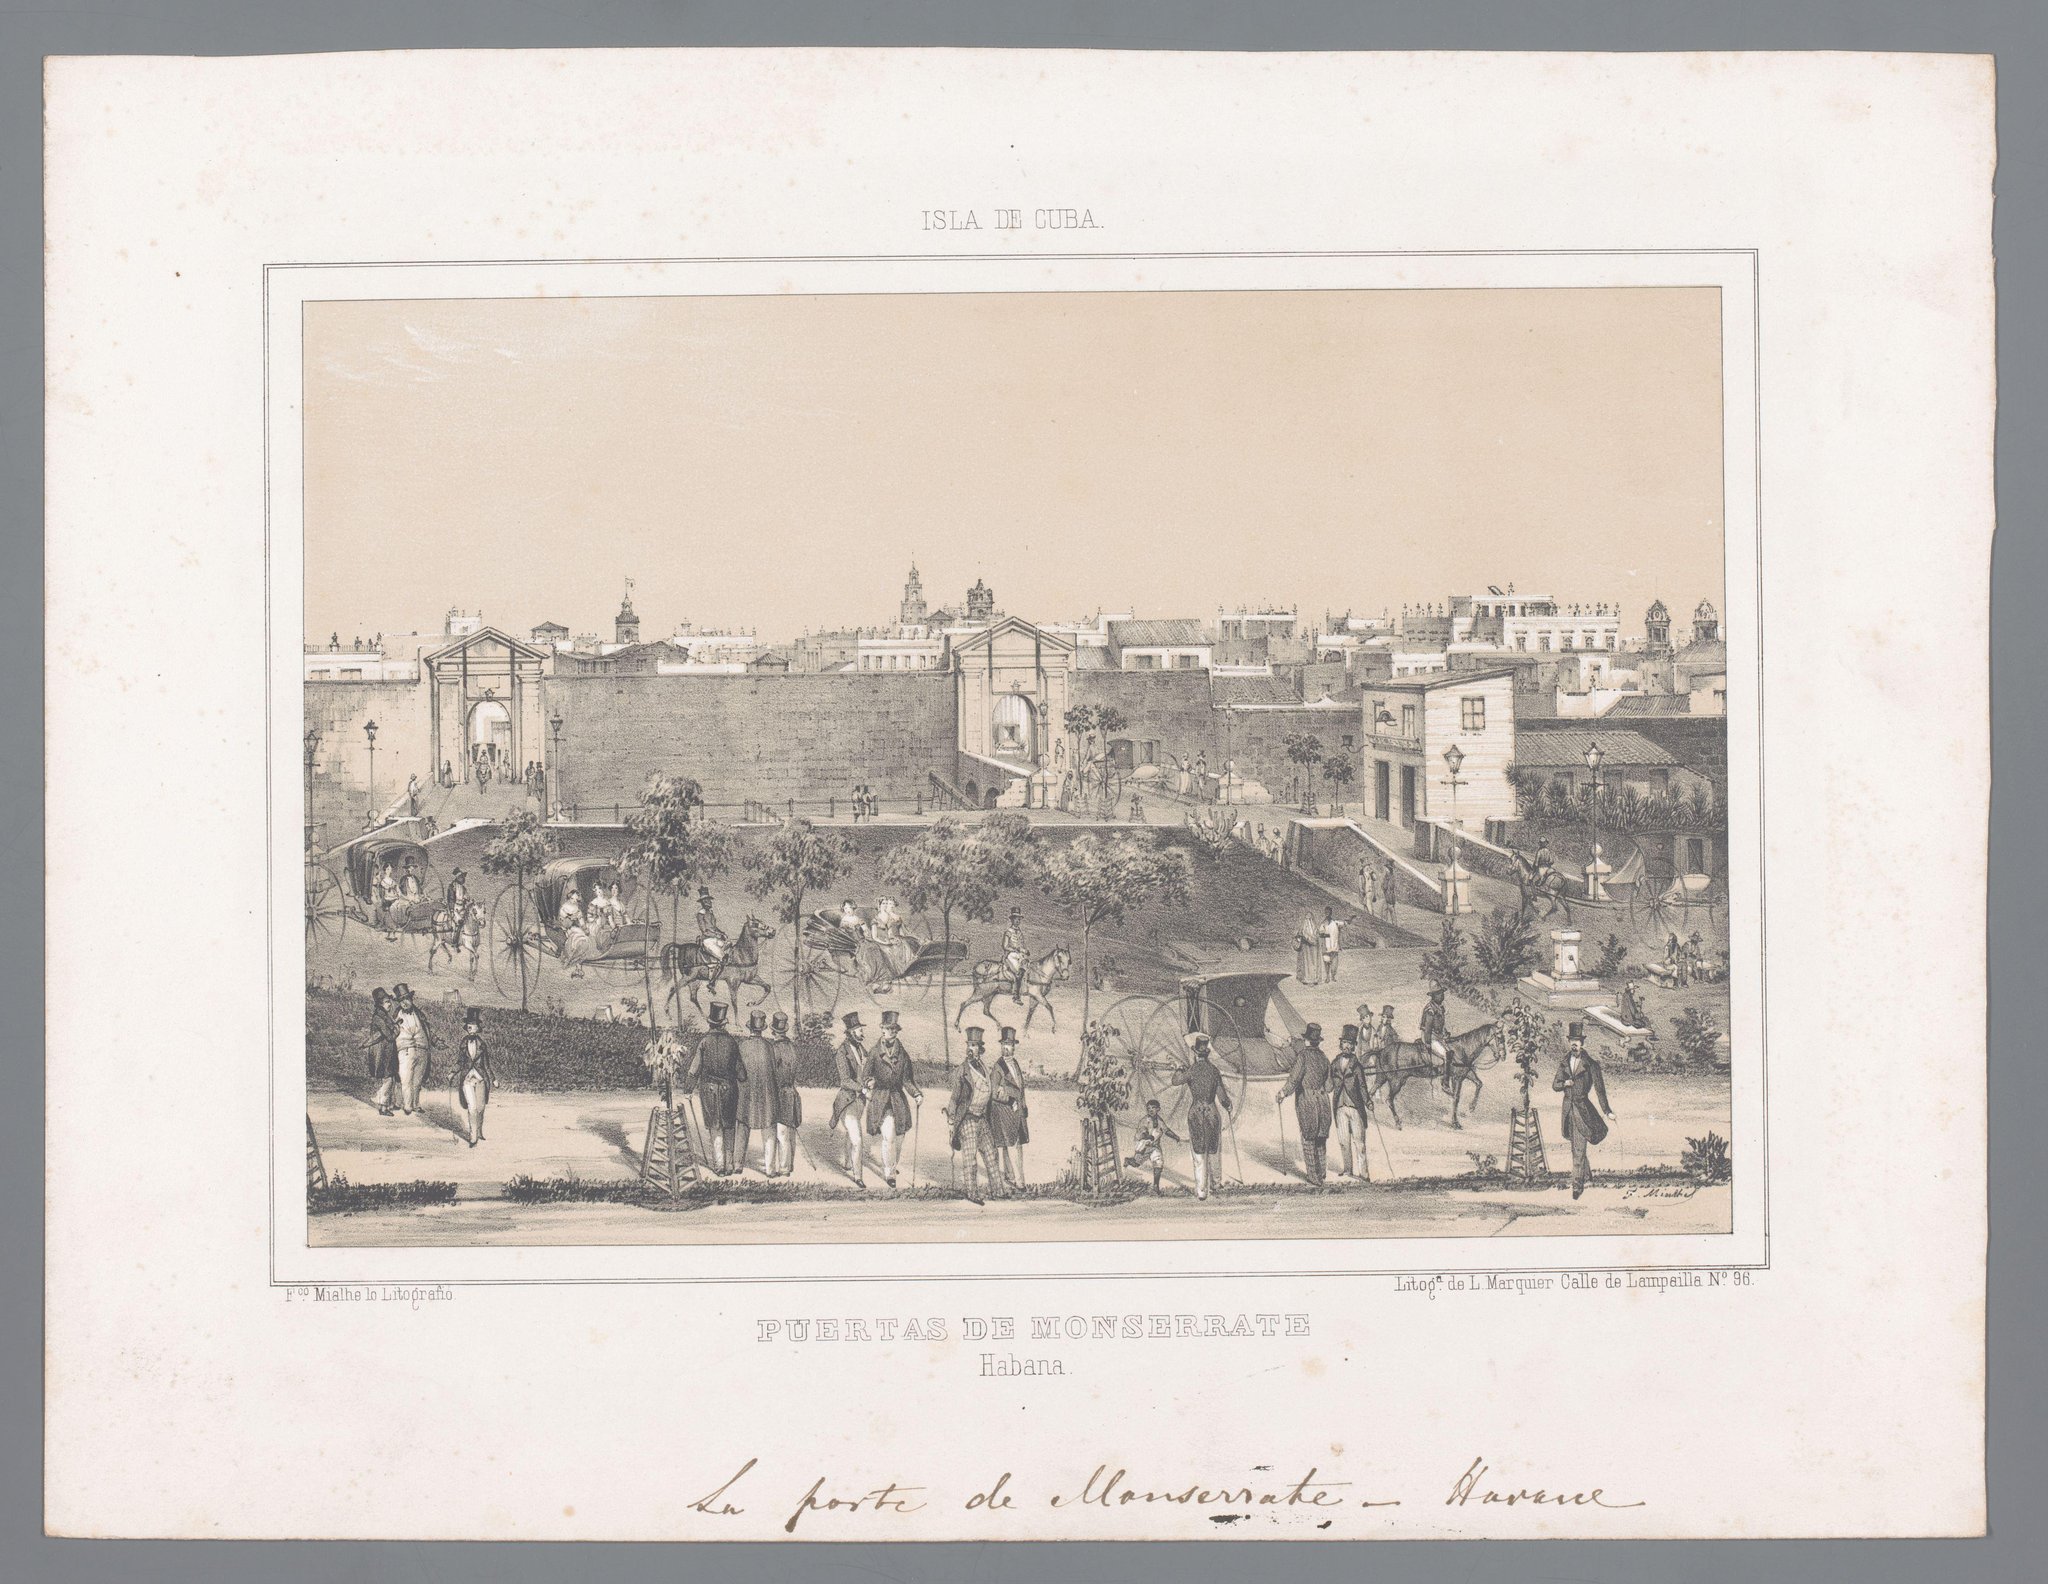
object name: print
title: Gezicht op de poorten van Havana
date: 1848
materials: paper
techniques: tone lithography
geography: cuba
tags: diligence, omnibus, horse-tram, city-view, and landscape with man-made constructions, city-walls, city-gate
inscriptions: collector's mark: Lugt 2228